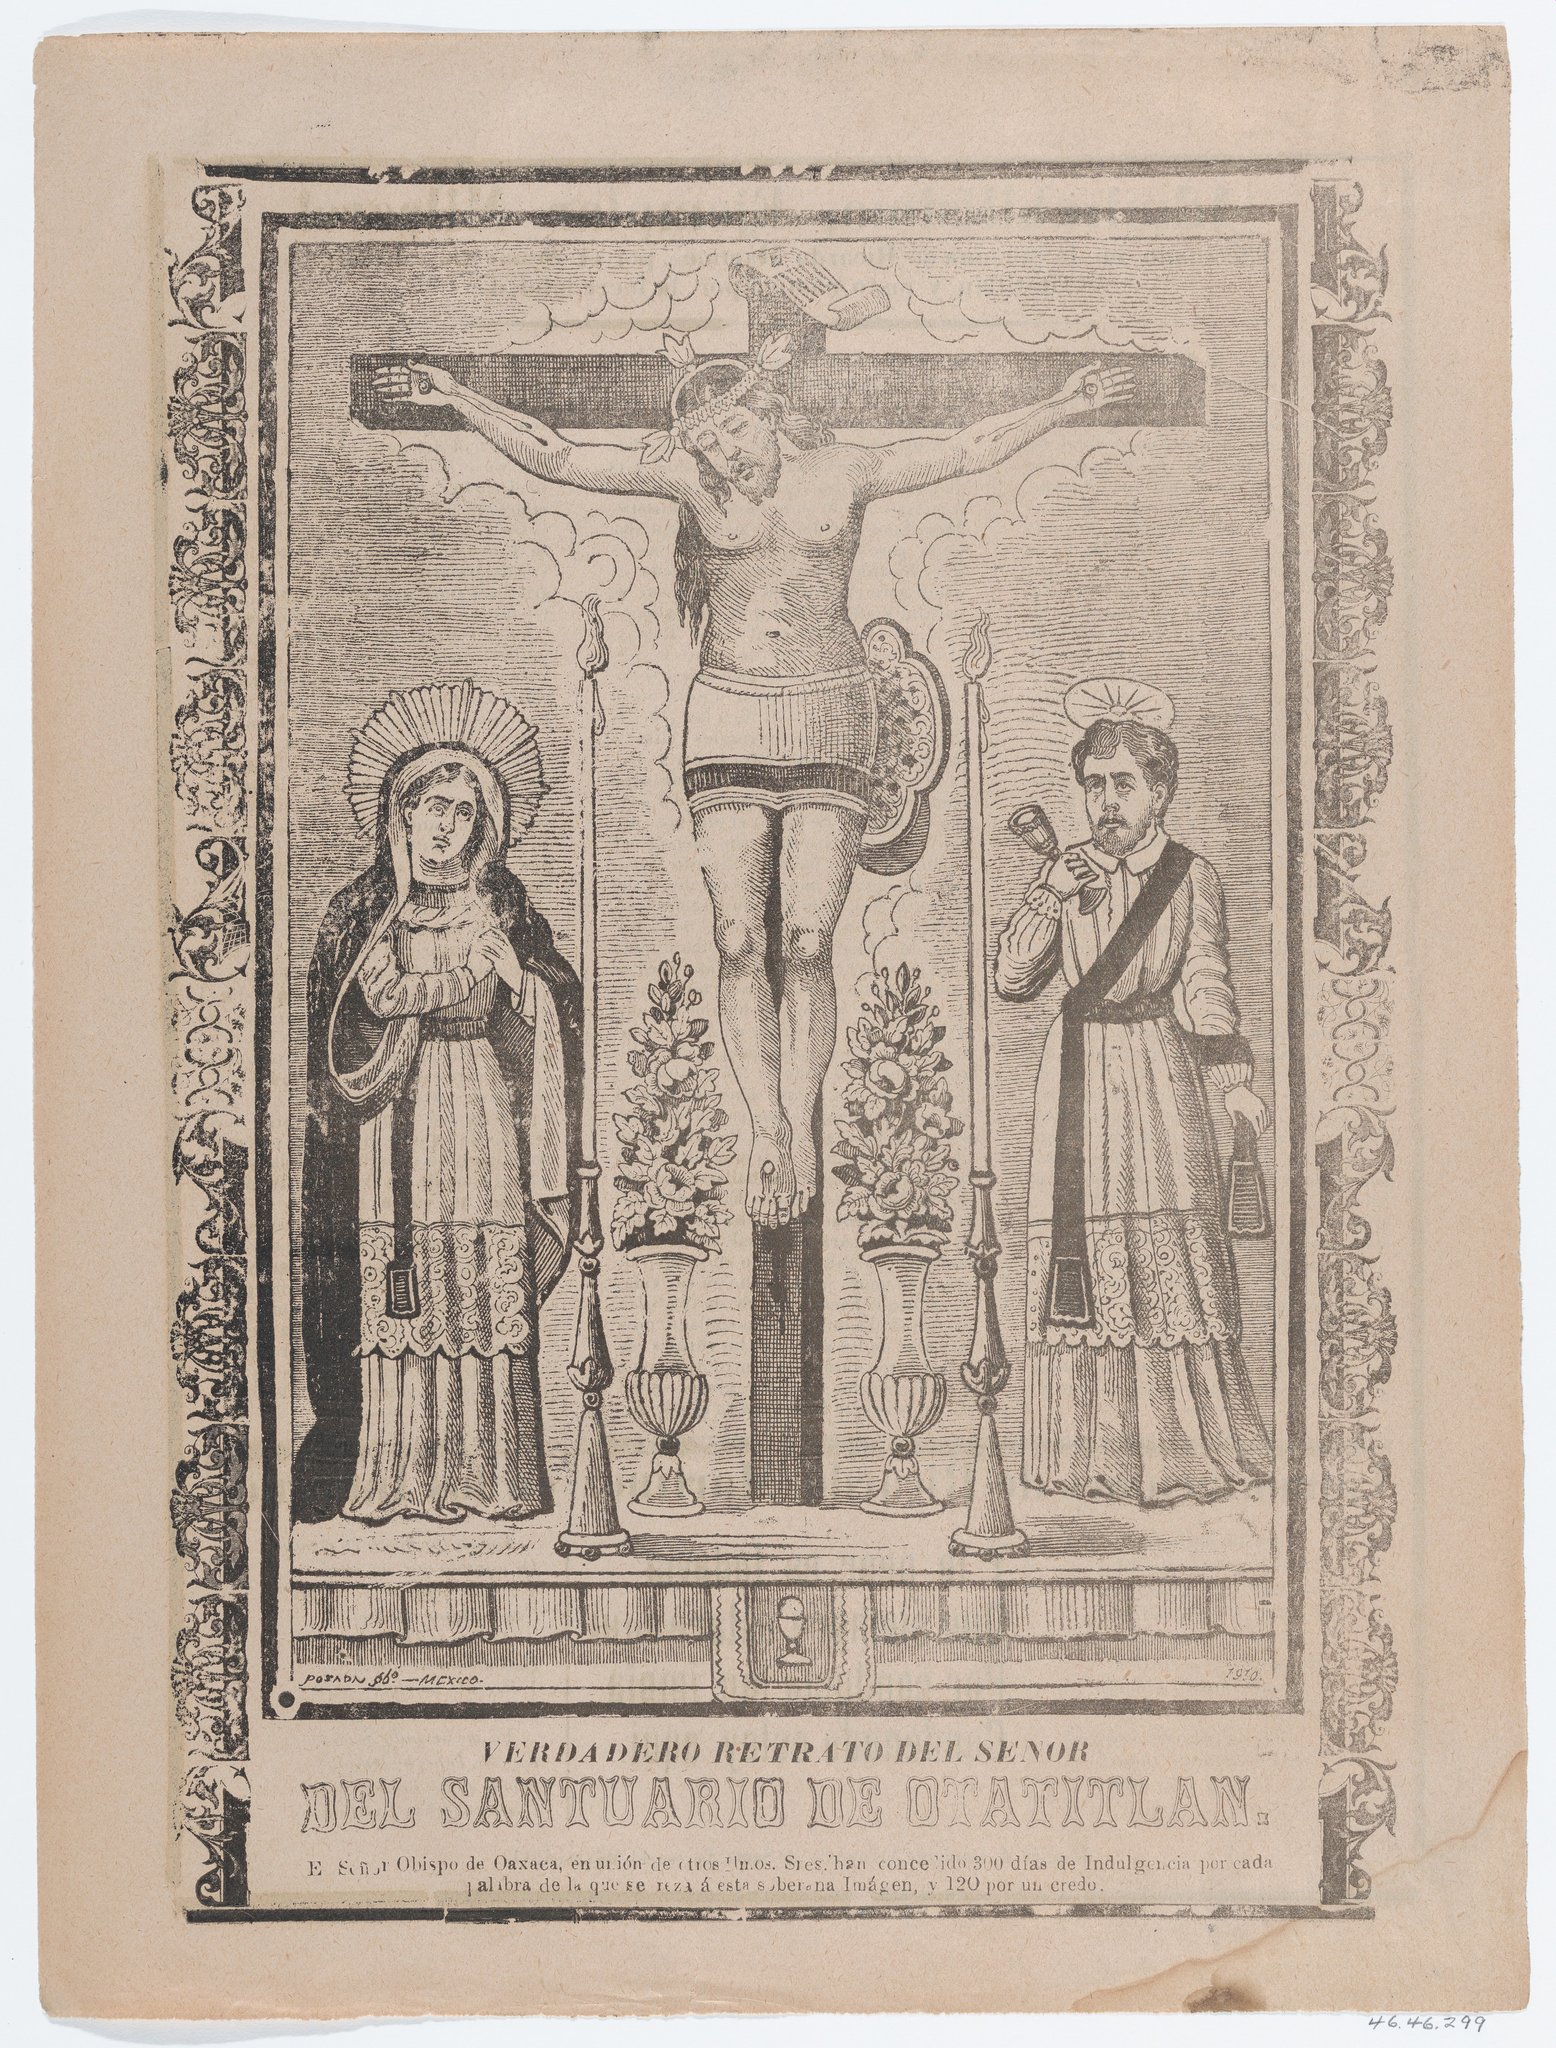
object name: print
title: An indulgence with an image of Our Lord of Chalma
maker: josé guadalupe posada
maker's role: artist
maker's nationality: mexican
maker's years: 1852-1913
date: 1900-1910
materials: paper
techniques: letterpress, lithograph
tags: christ,saint john the baptist,virgin mary,crucifixion